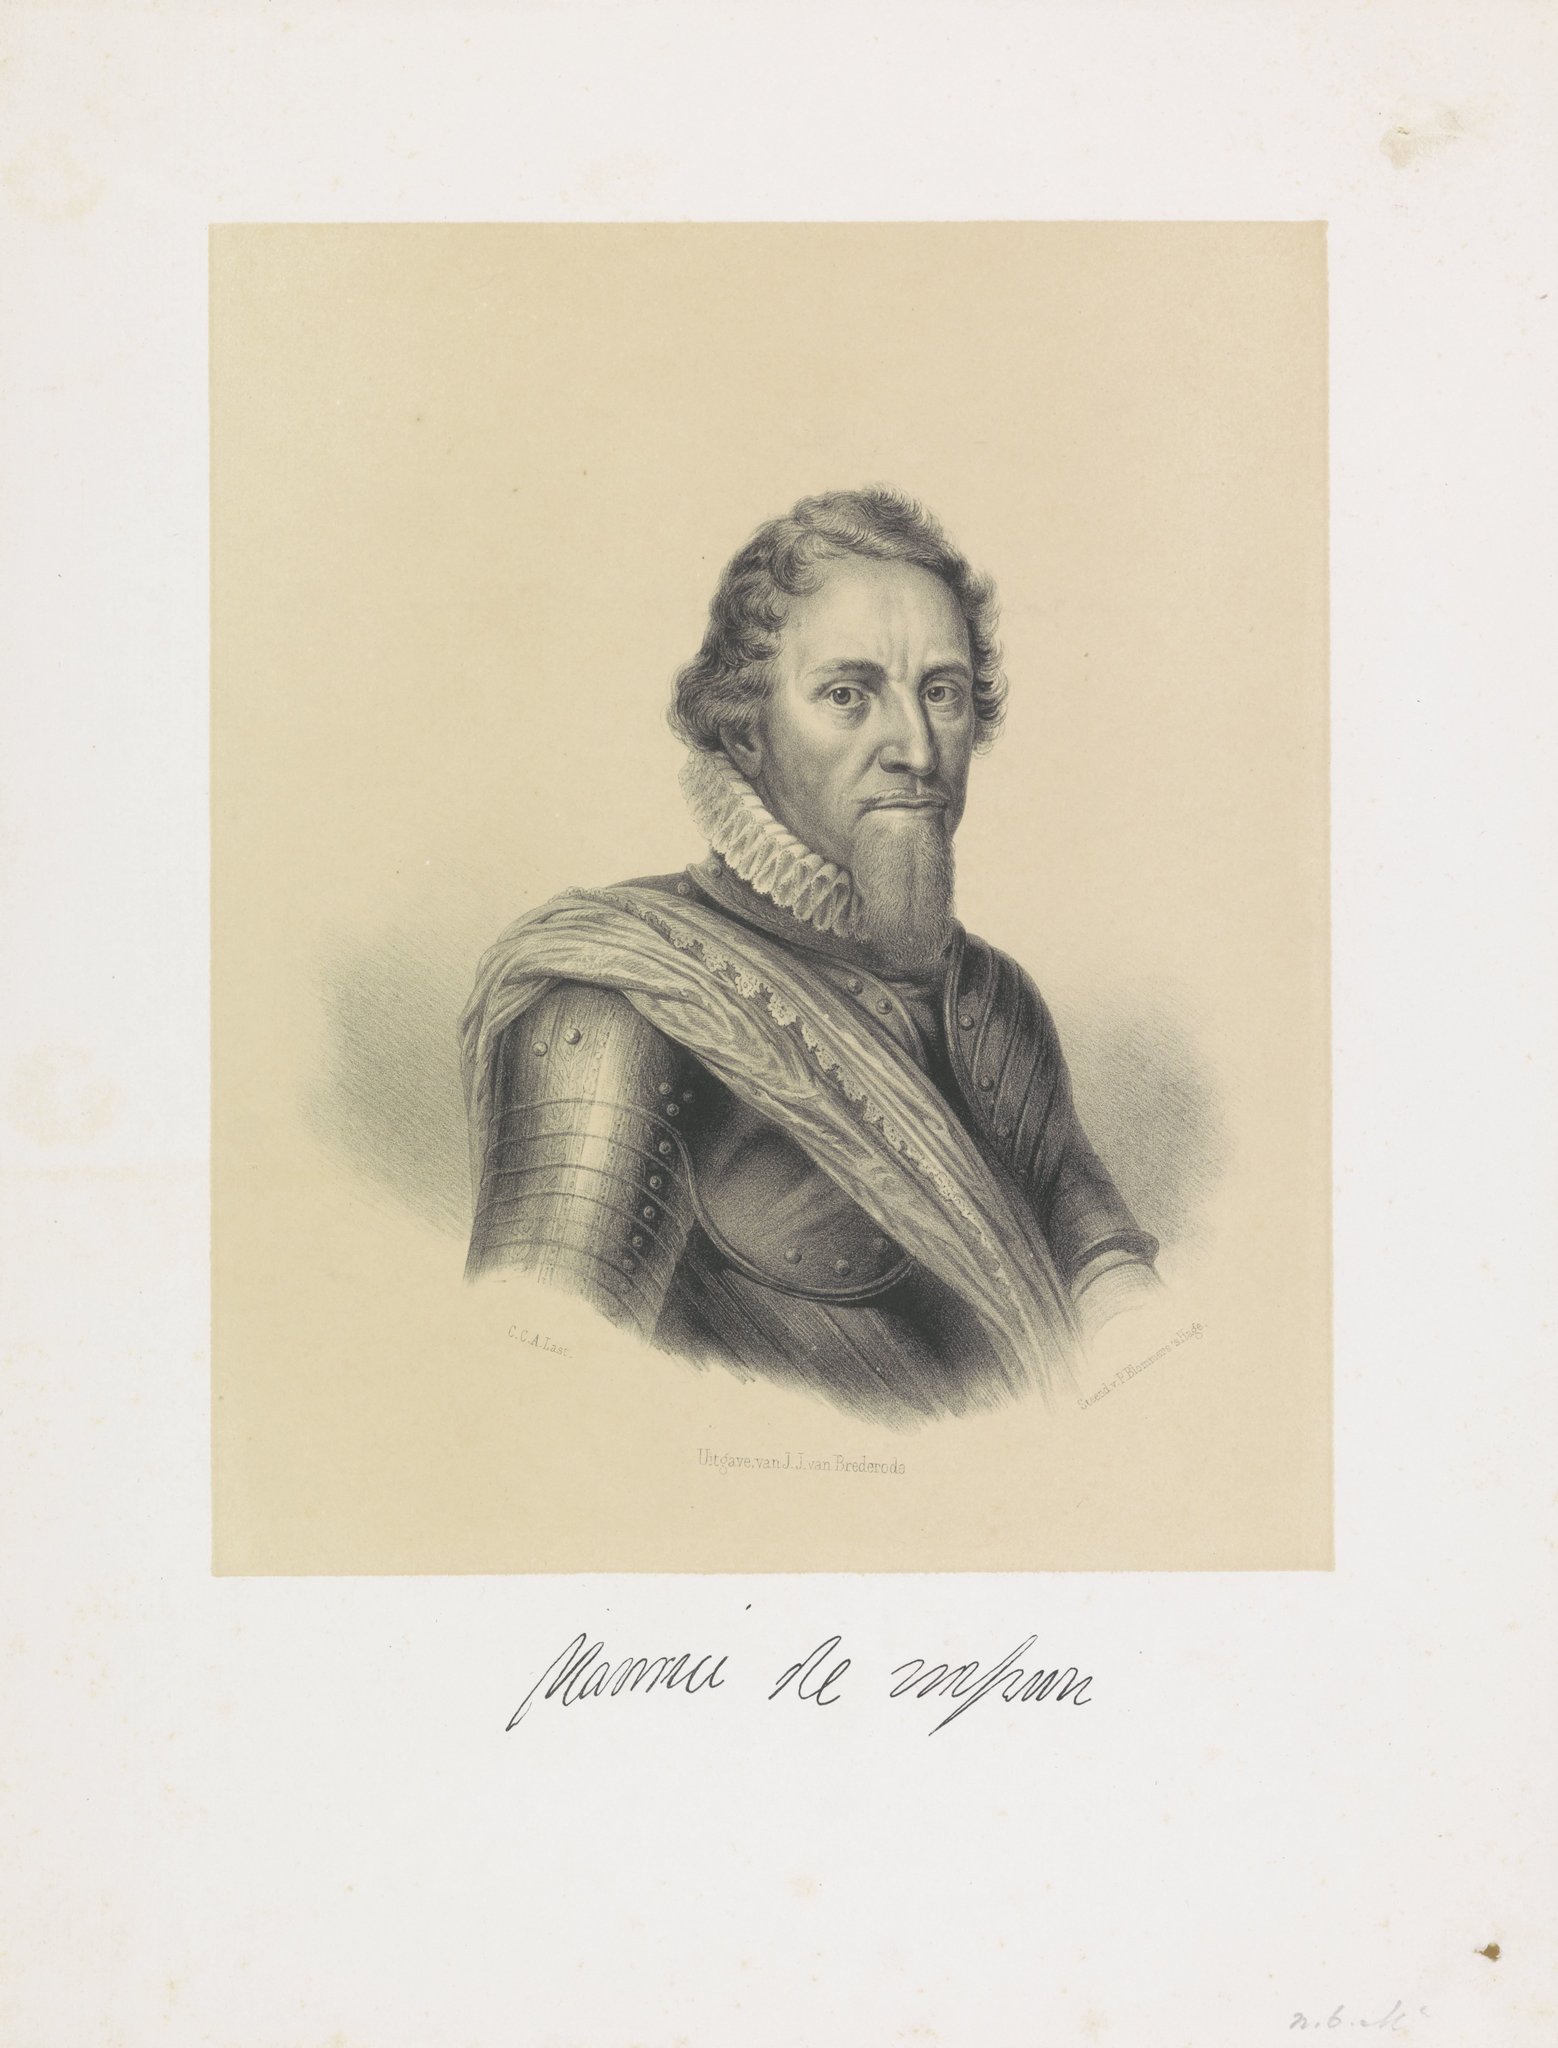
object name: print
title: Portret van Maurits, prins van Oranje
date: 1847-1883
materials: paper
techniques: tone lithography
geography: haarlem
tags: maurice (prince of orange)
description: De hier vermelde titel verwijst naar de hoogst verkregen titel van de geportretteerde, niet per se naar de titel die de geportretteerde op deze voorstelling draagt.